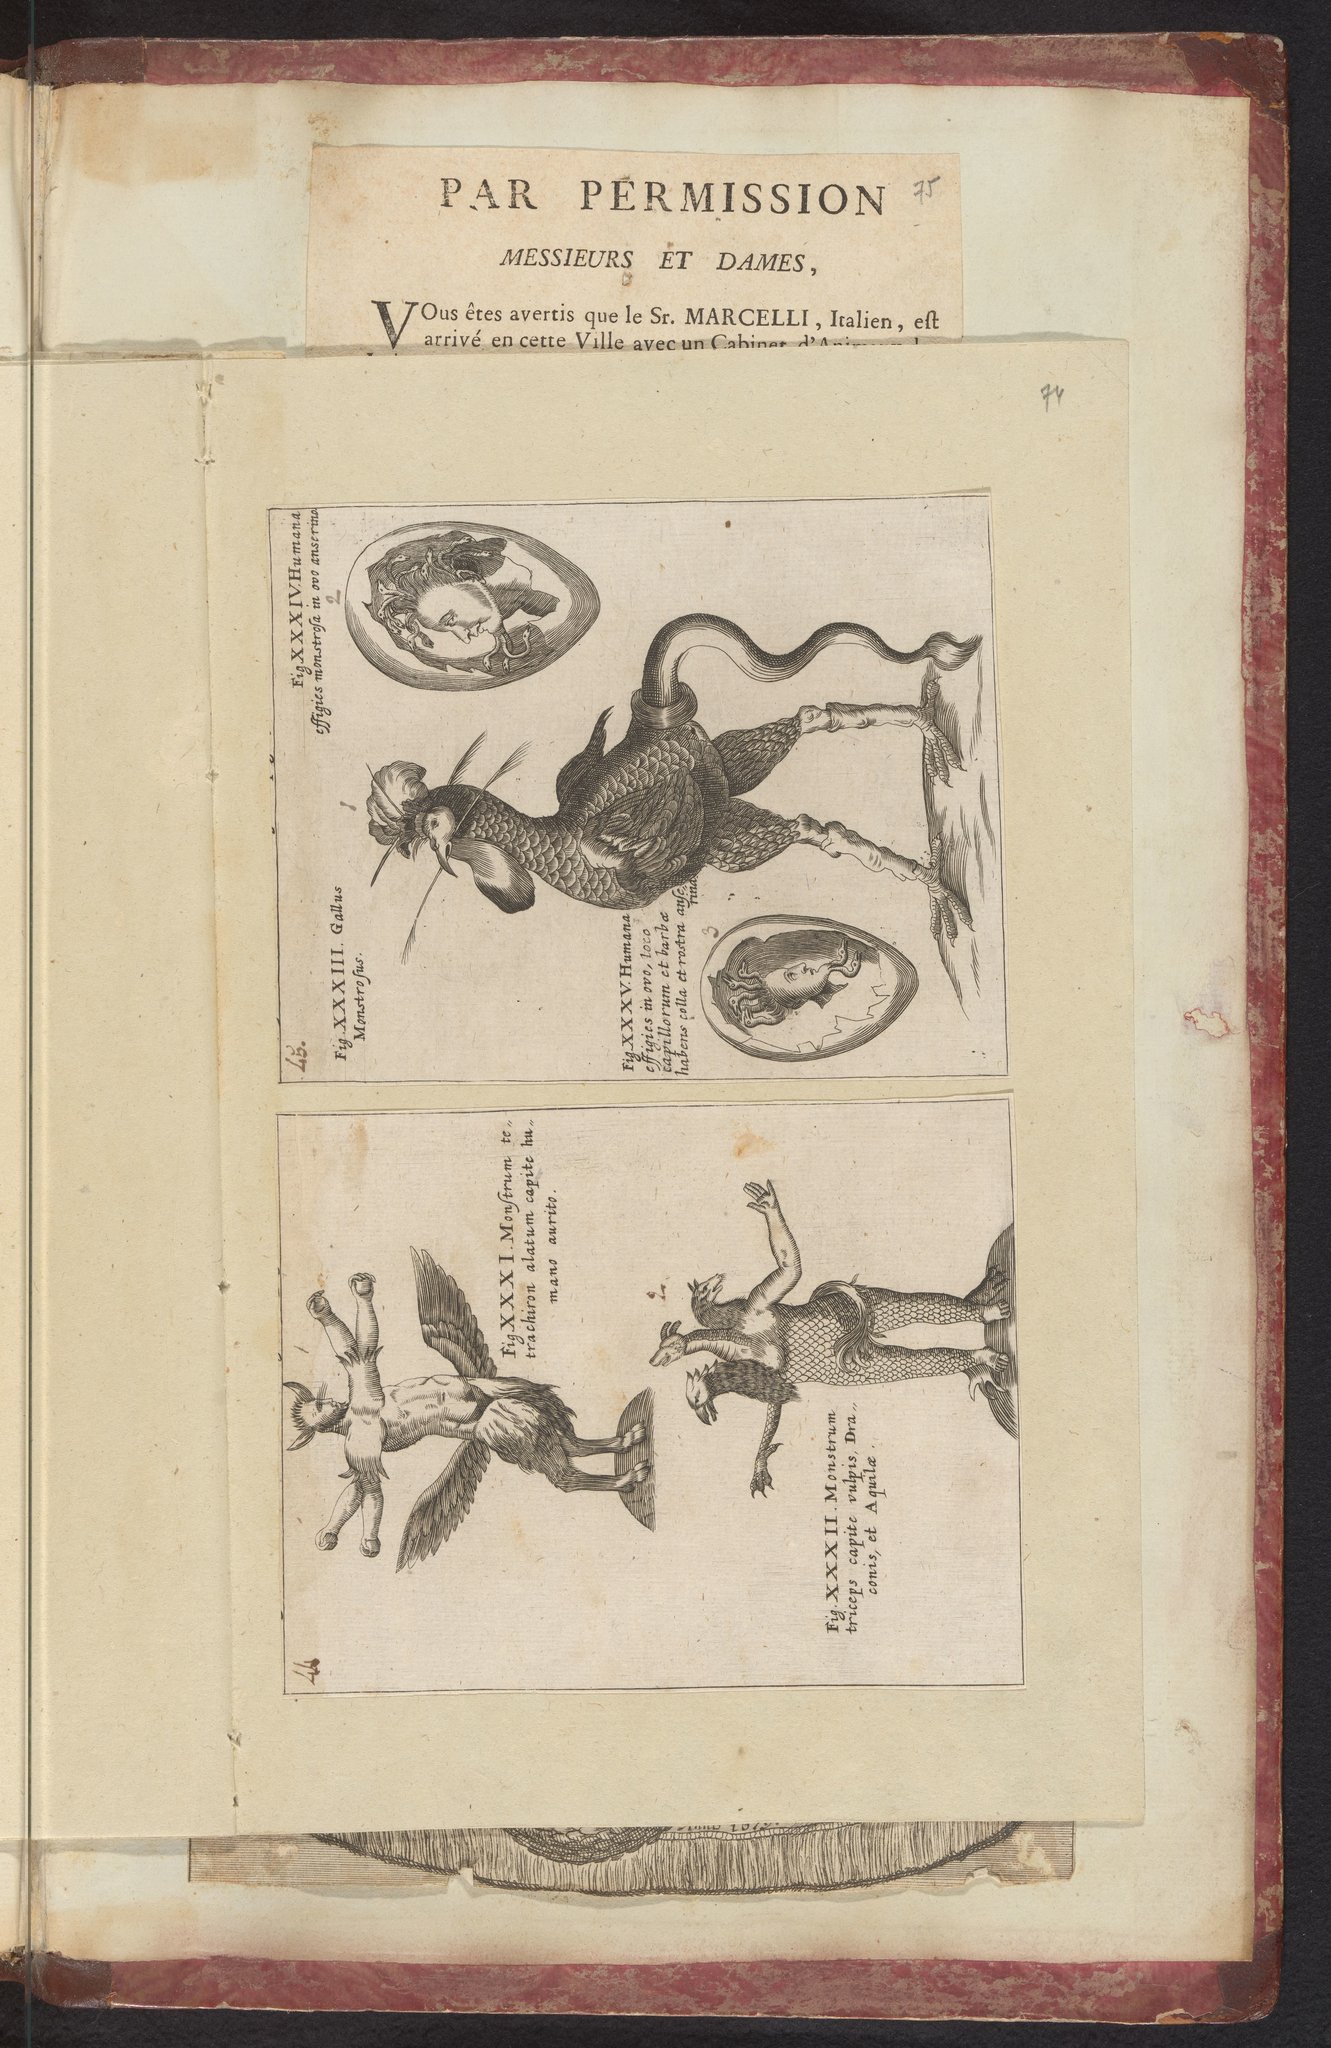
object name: print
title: Monsterlijke dieren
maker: Anonymous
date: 1665-1667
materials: paper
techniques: engraving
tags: mis-shapen animals; monsters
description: Twee ingeplakte prenten met Monsterlijke dieren. Links twee monsters (Fig. XXXI-XXXII). Linksboven genummerd: 44. Rechts een misvormde haan en twee eieren met Mudusa-hoofden (Fig. XXXIII-XXXV). Linksboven genummerd: 45. Op een kleiner formaat blad papier. Onderdeel van het zevende album met tekeningen van reptielen, amfibieën en natuurhistorische ensembles. Het zevende van twaalf albums met aquarellen van dieren, vogels en planten bekend rond 1600, gemaakt in opdracht van keizer Rudolf II. Met toelichting in Nederlands, Latijn en Frans.